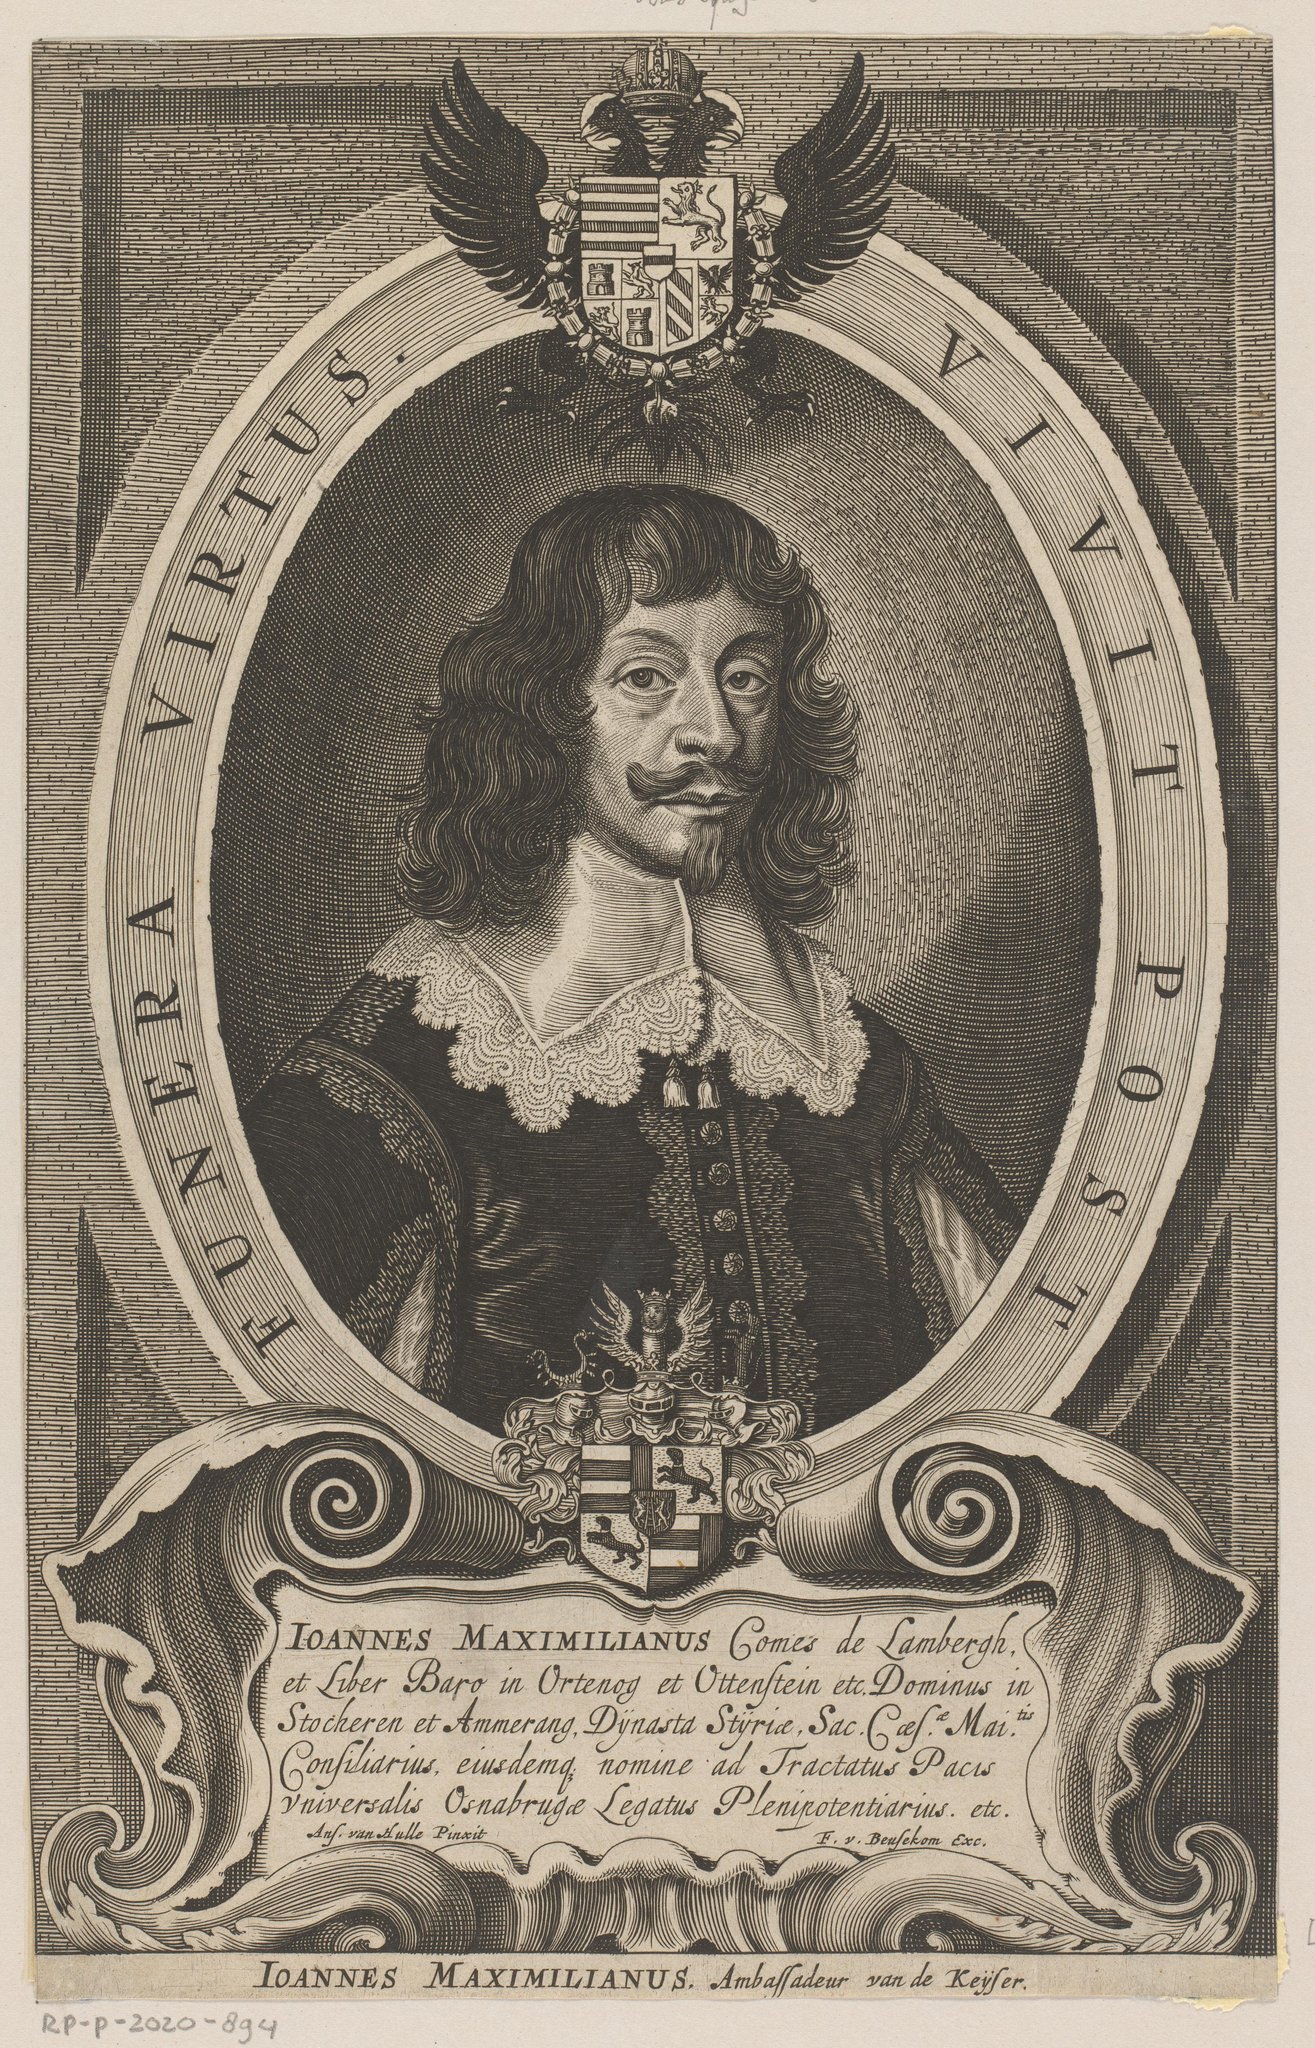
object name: print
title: Ioannes Maximilianus. Ambassadeur van de keyser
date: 1648-1665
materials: paper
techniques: engraving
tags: vienna, official; civil servant; functionary (in general), historical persons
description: Spiegelbeeldige kopie naar een prent van Pieter de Jode II. Zie documentatie. De prent maakt waarschijnlijk onderdeel uit van een serie portretten met vredesonderhandelaars die betrokken waren bij de Vrede van Münster.